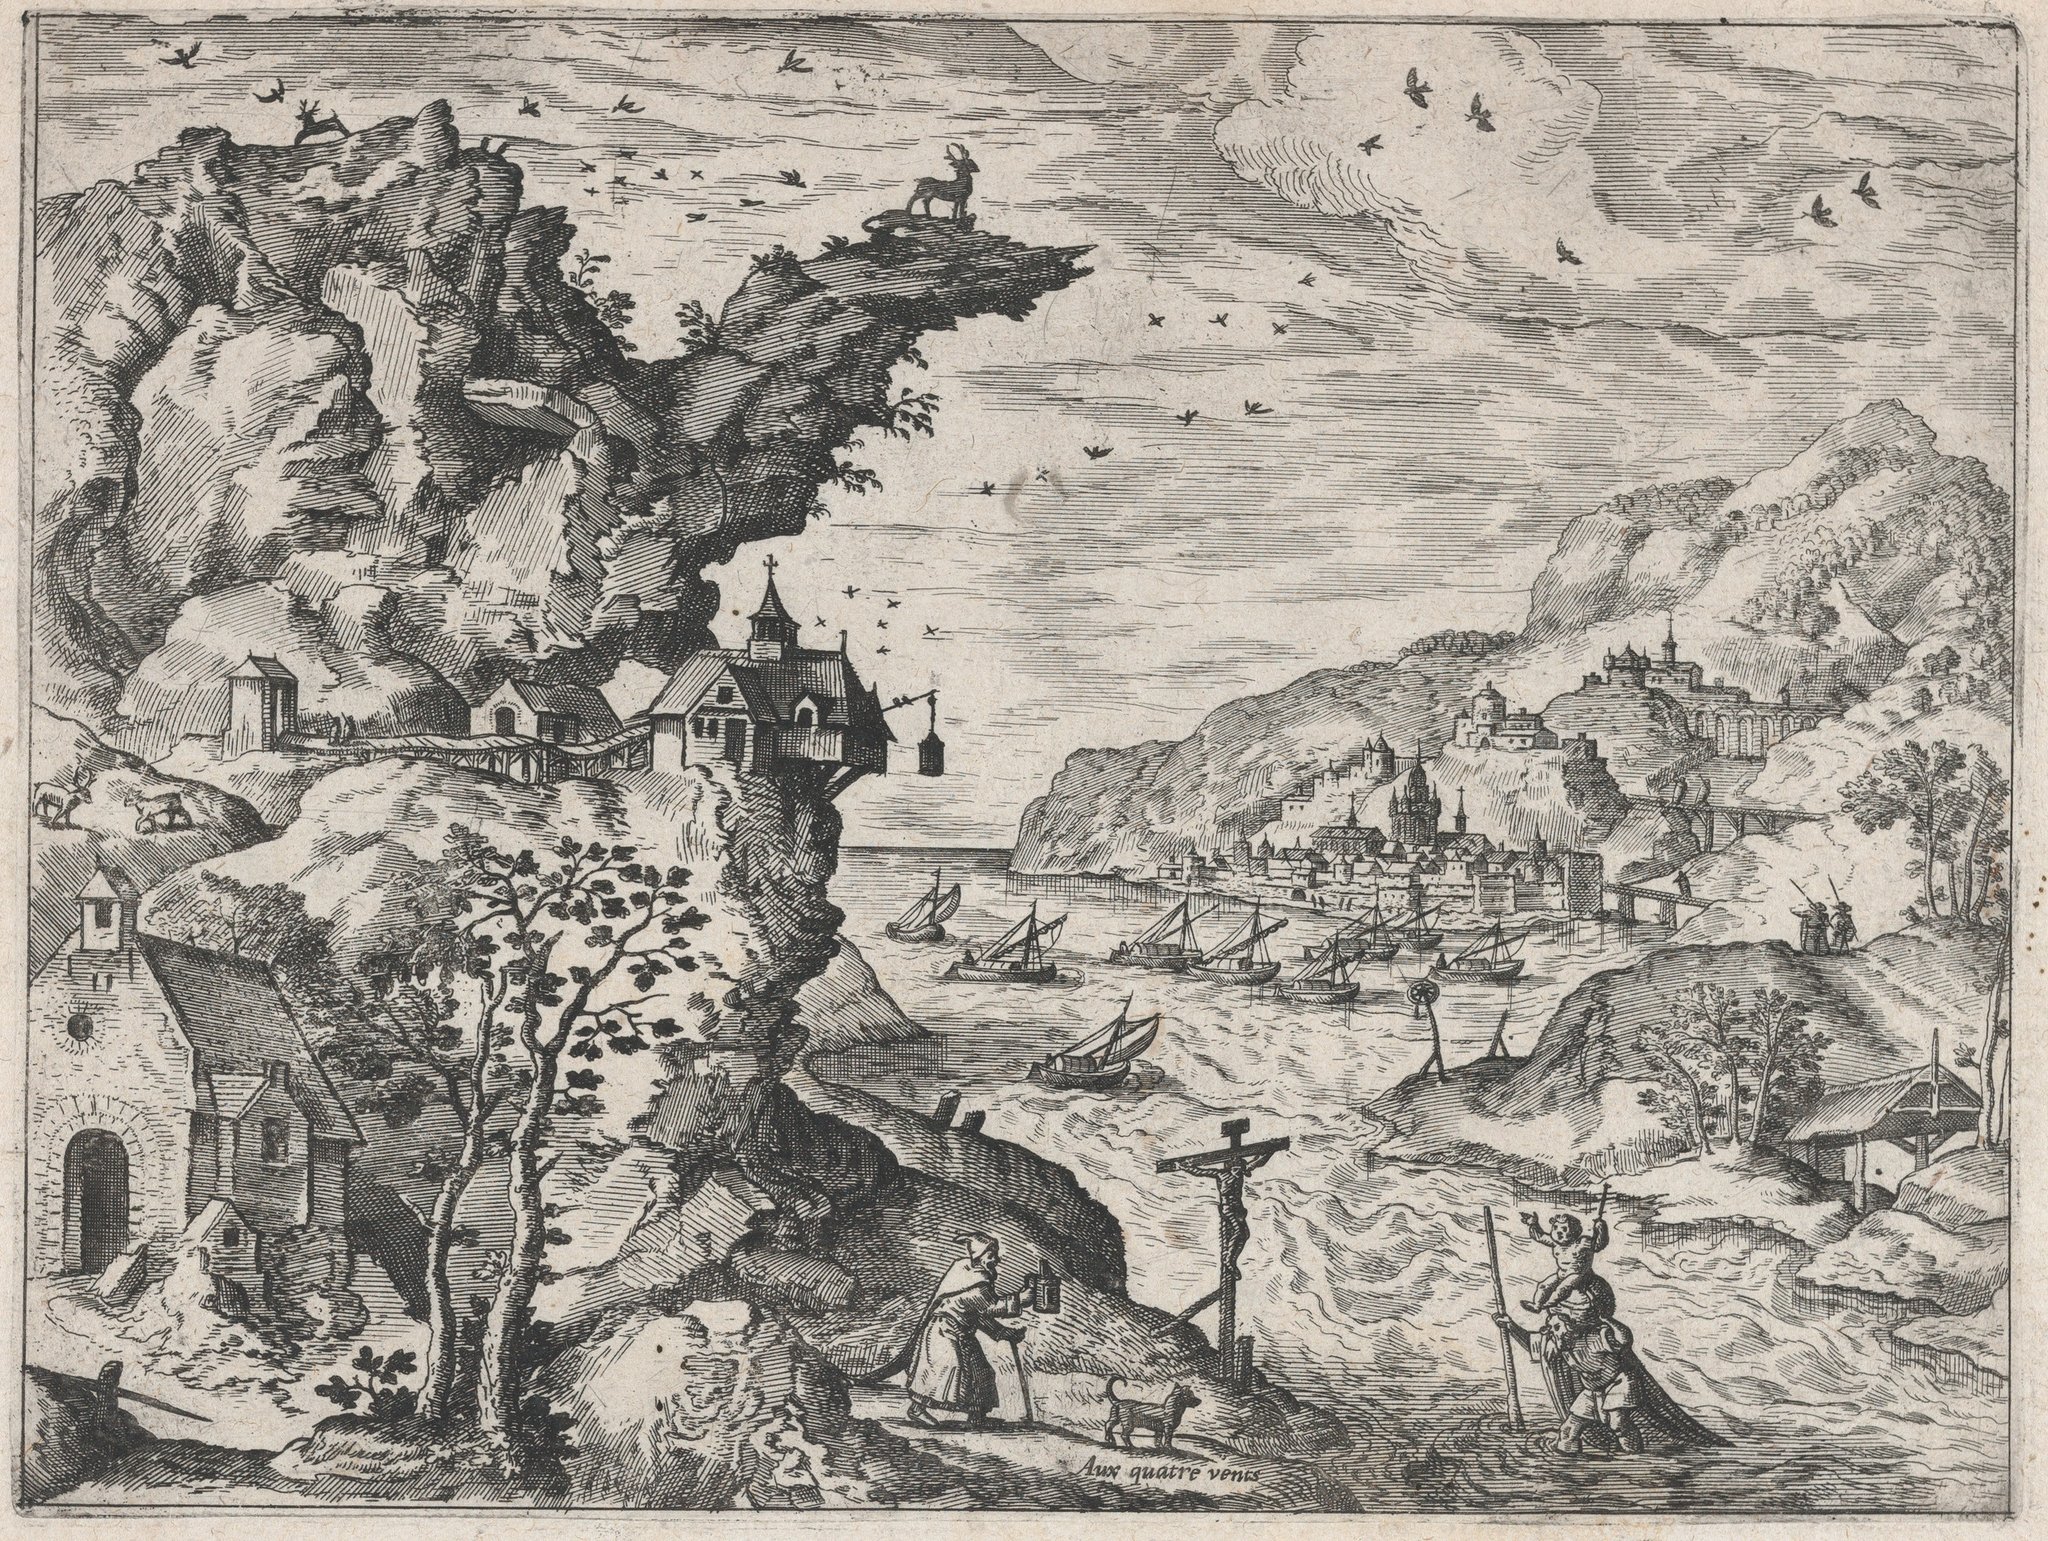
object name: print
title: Landscape with Saint Christopher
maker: lucas gassel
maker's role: artist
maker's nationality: netherlandish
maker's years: 1495-1500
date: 1560-1570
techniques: engraving, etching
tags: houses,landscapes,saint christopher,boats